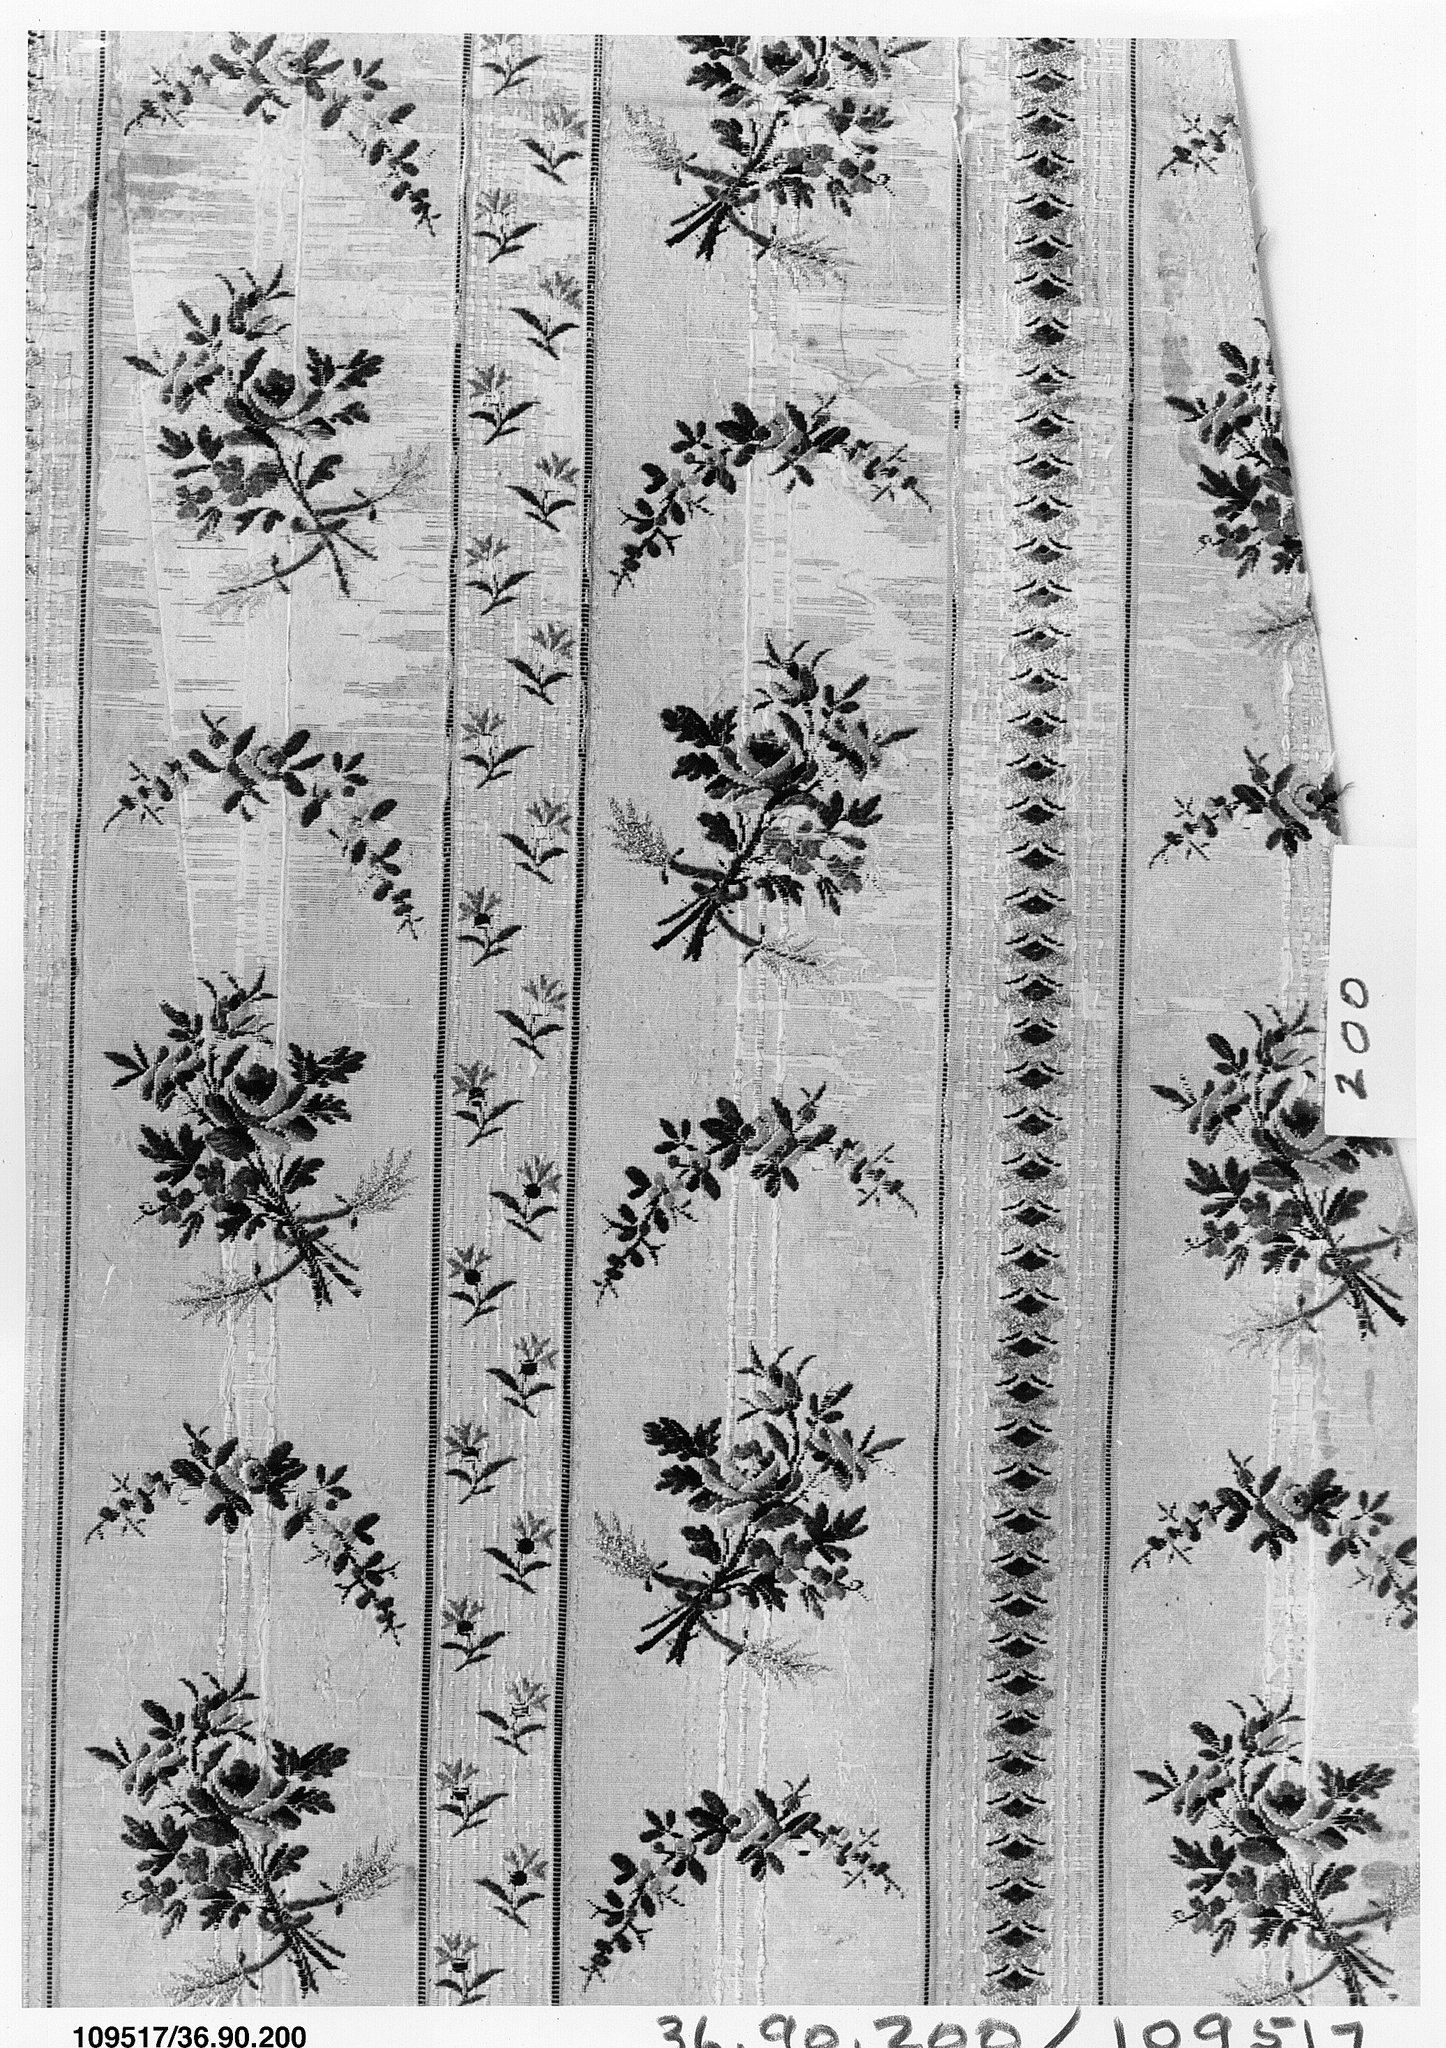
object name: piece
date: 1780-1790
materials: metal thread, silk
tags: flowers,leaves